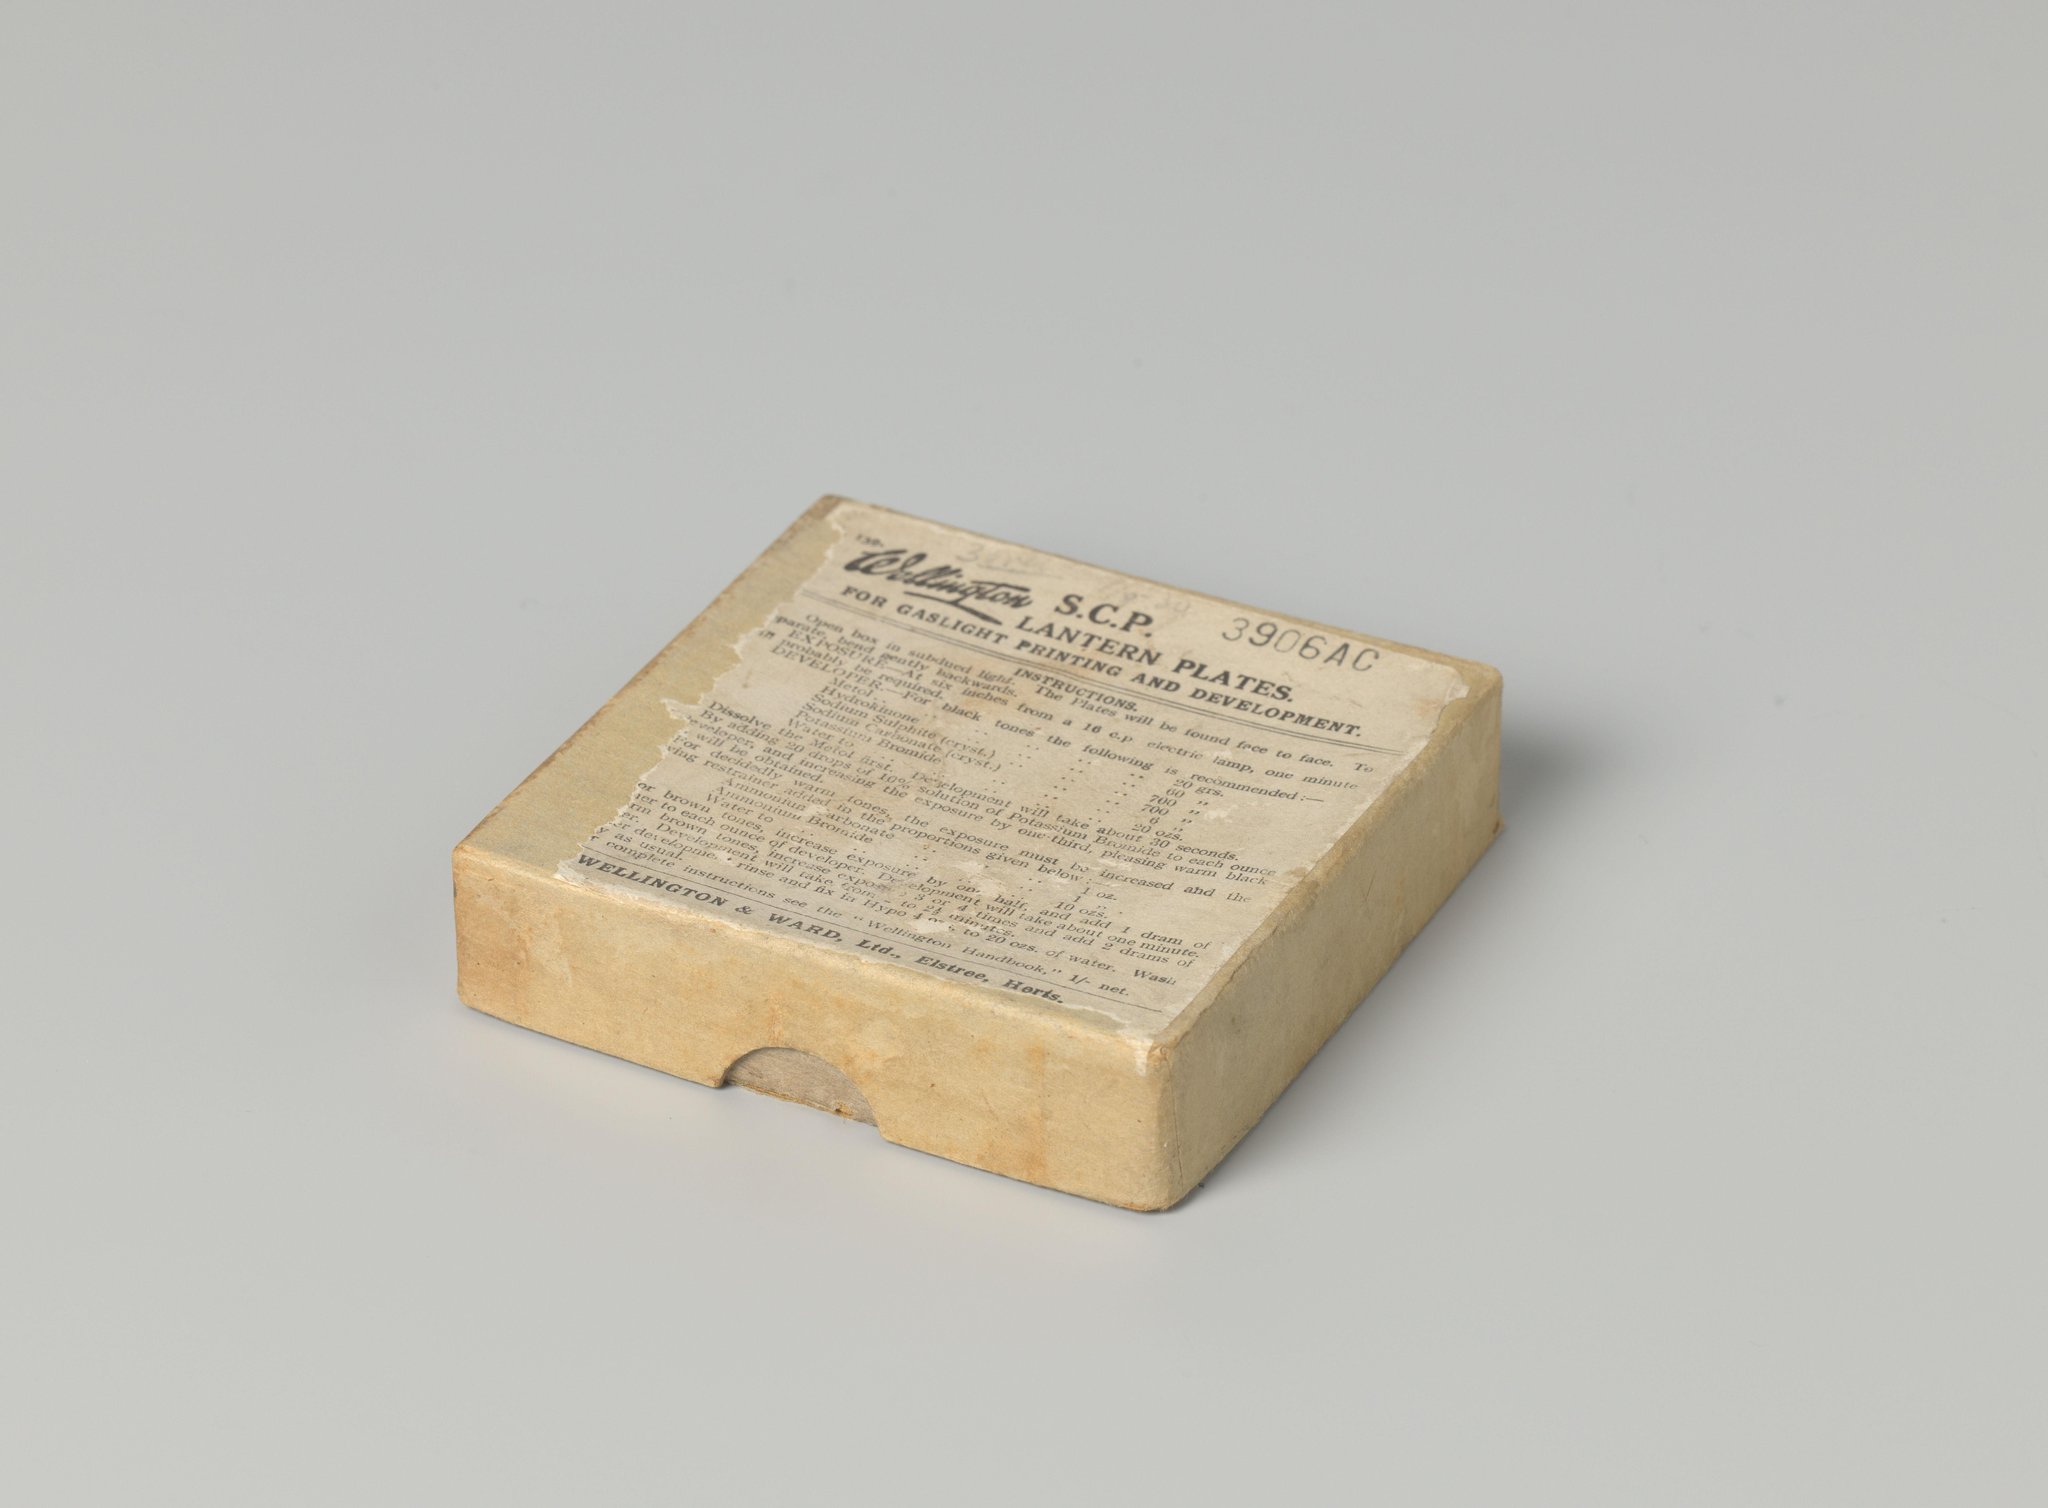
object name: box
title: Doos voor glasplaten van Wellington & Ward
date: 1890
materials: cardboard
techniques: printing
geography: elstree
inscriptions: number: ‘3906AC’